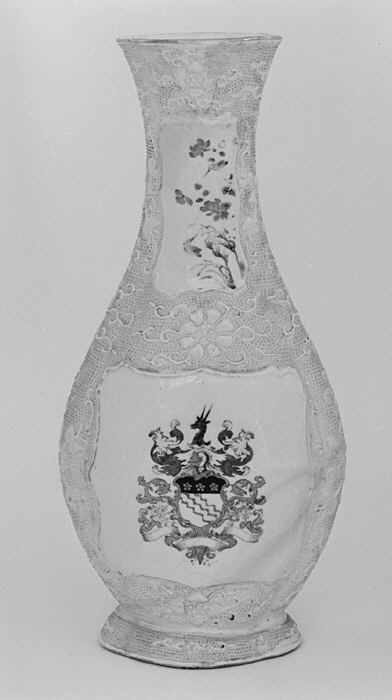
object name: vase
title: Vase (part of a garniture)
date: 1750-1760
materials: hard paste porcelain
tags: flowers,coat of arms